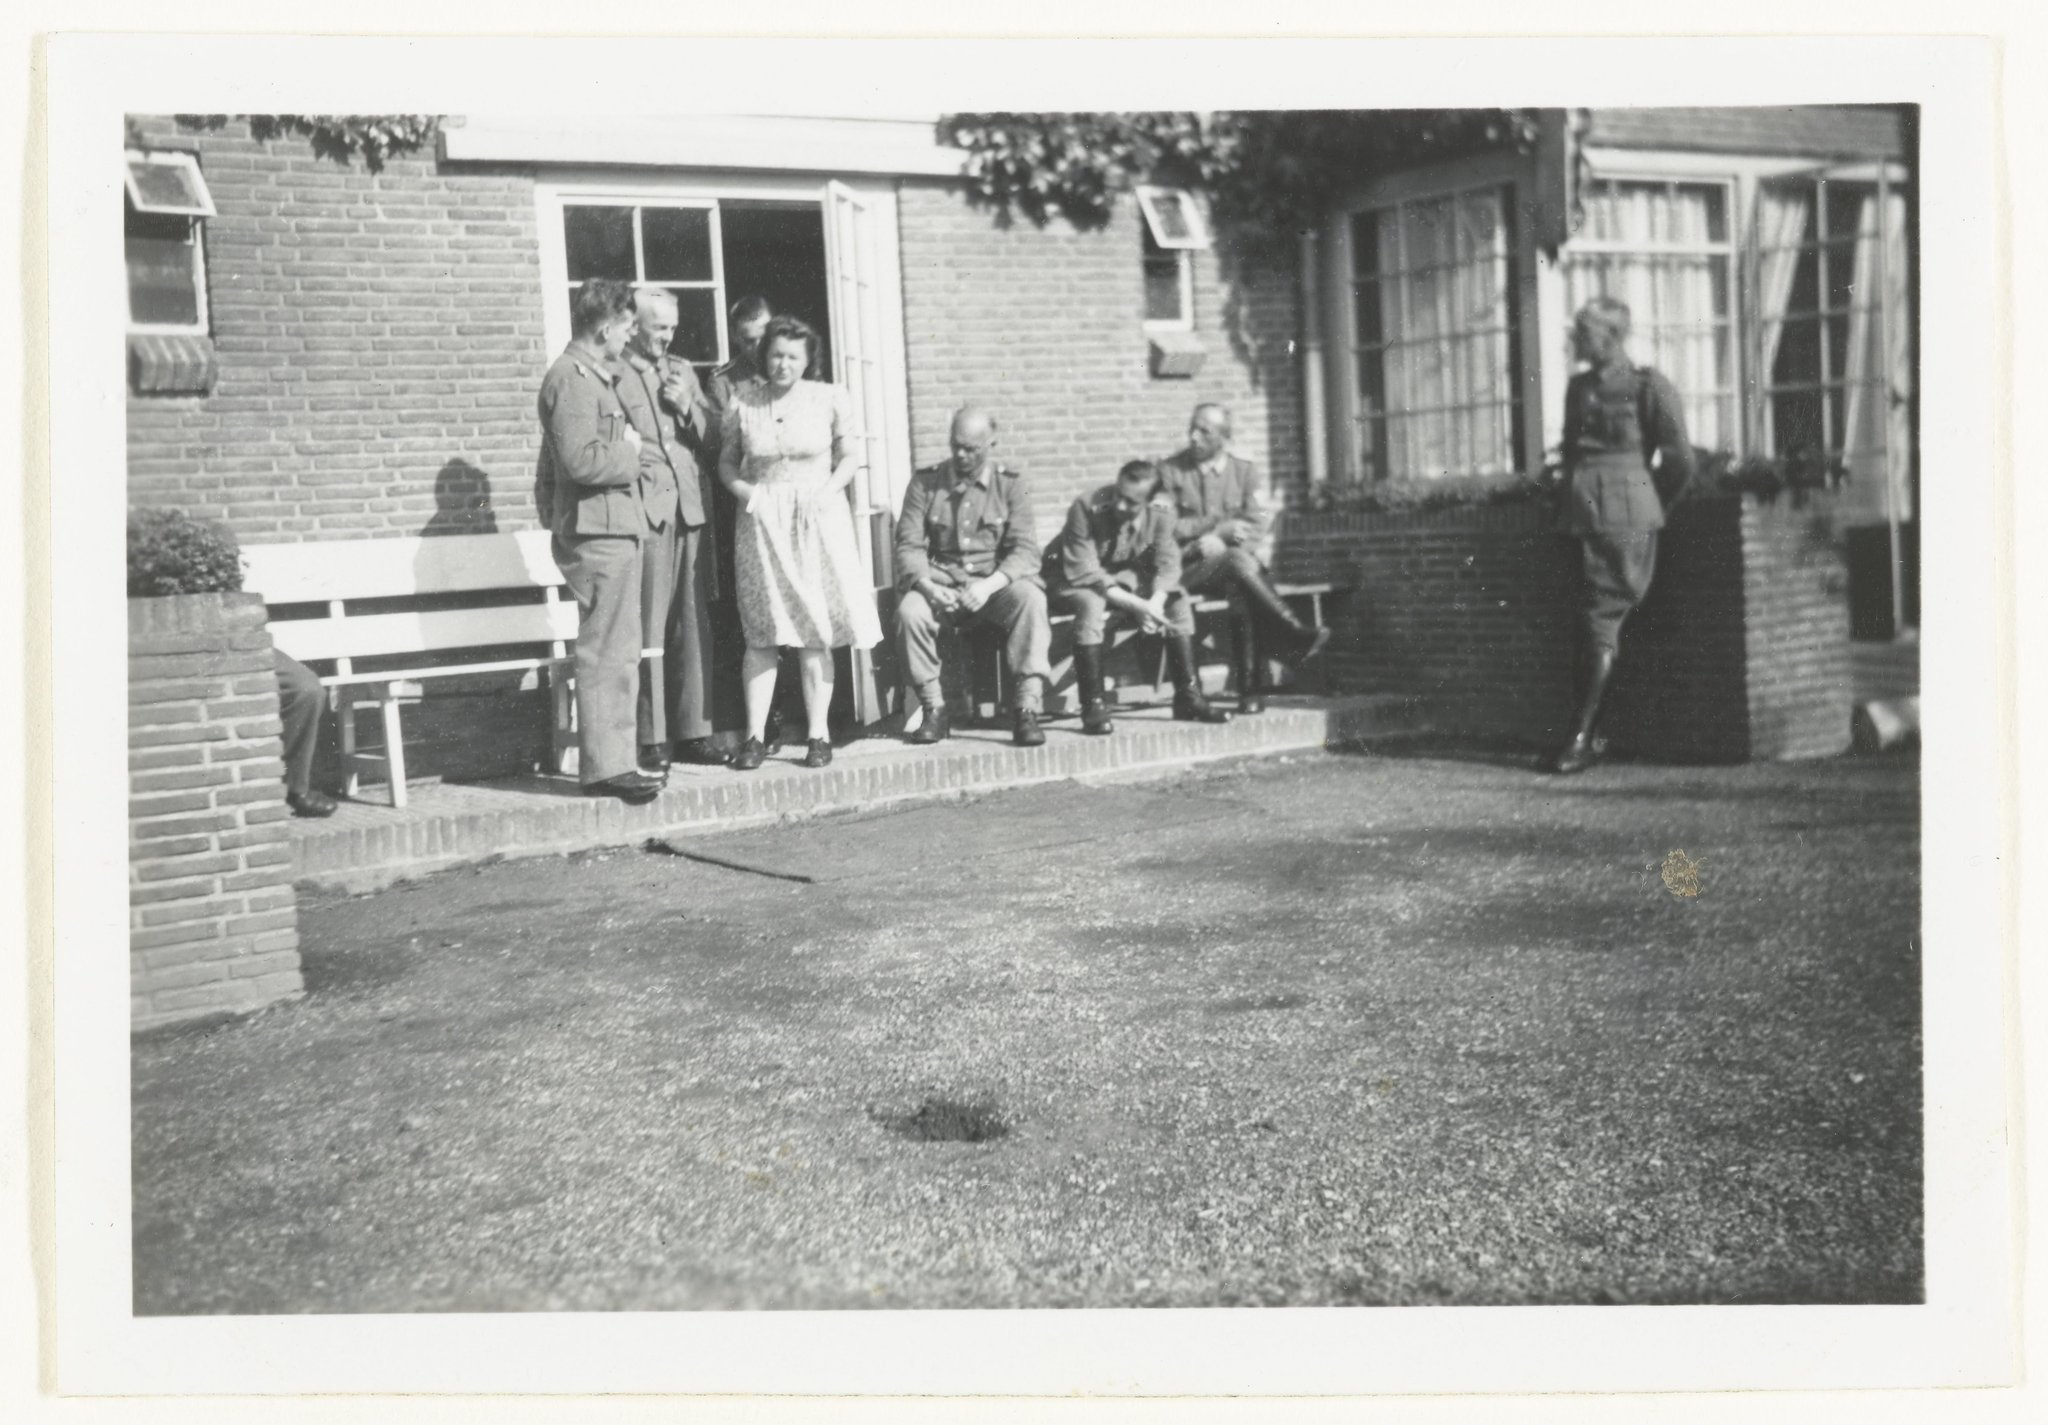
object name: photograph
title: Wehrmacht militairen bij een huis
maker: Anonymous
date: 1940-1942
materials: photographic support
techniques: gelatin silver print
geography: netherlands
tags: occupier and civilians, occupation ~ war, netherlands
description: Wehrmacht militairen en een vrouw staan en zitten voor een huis. Links staat een witte bank.